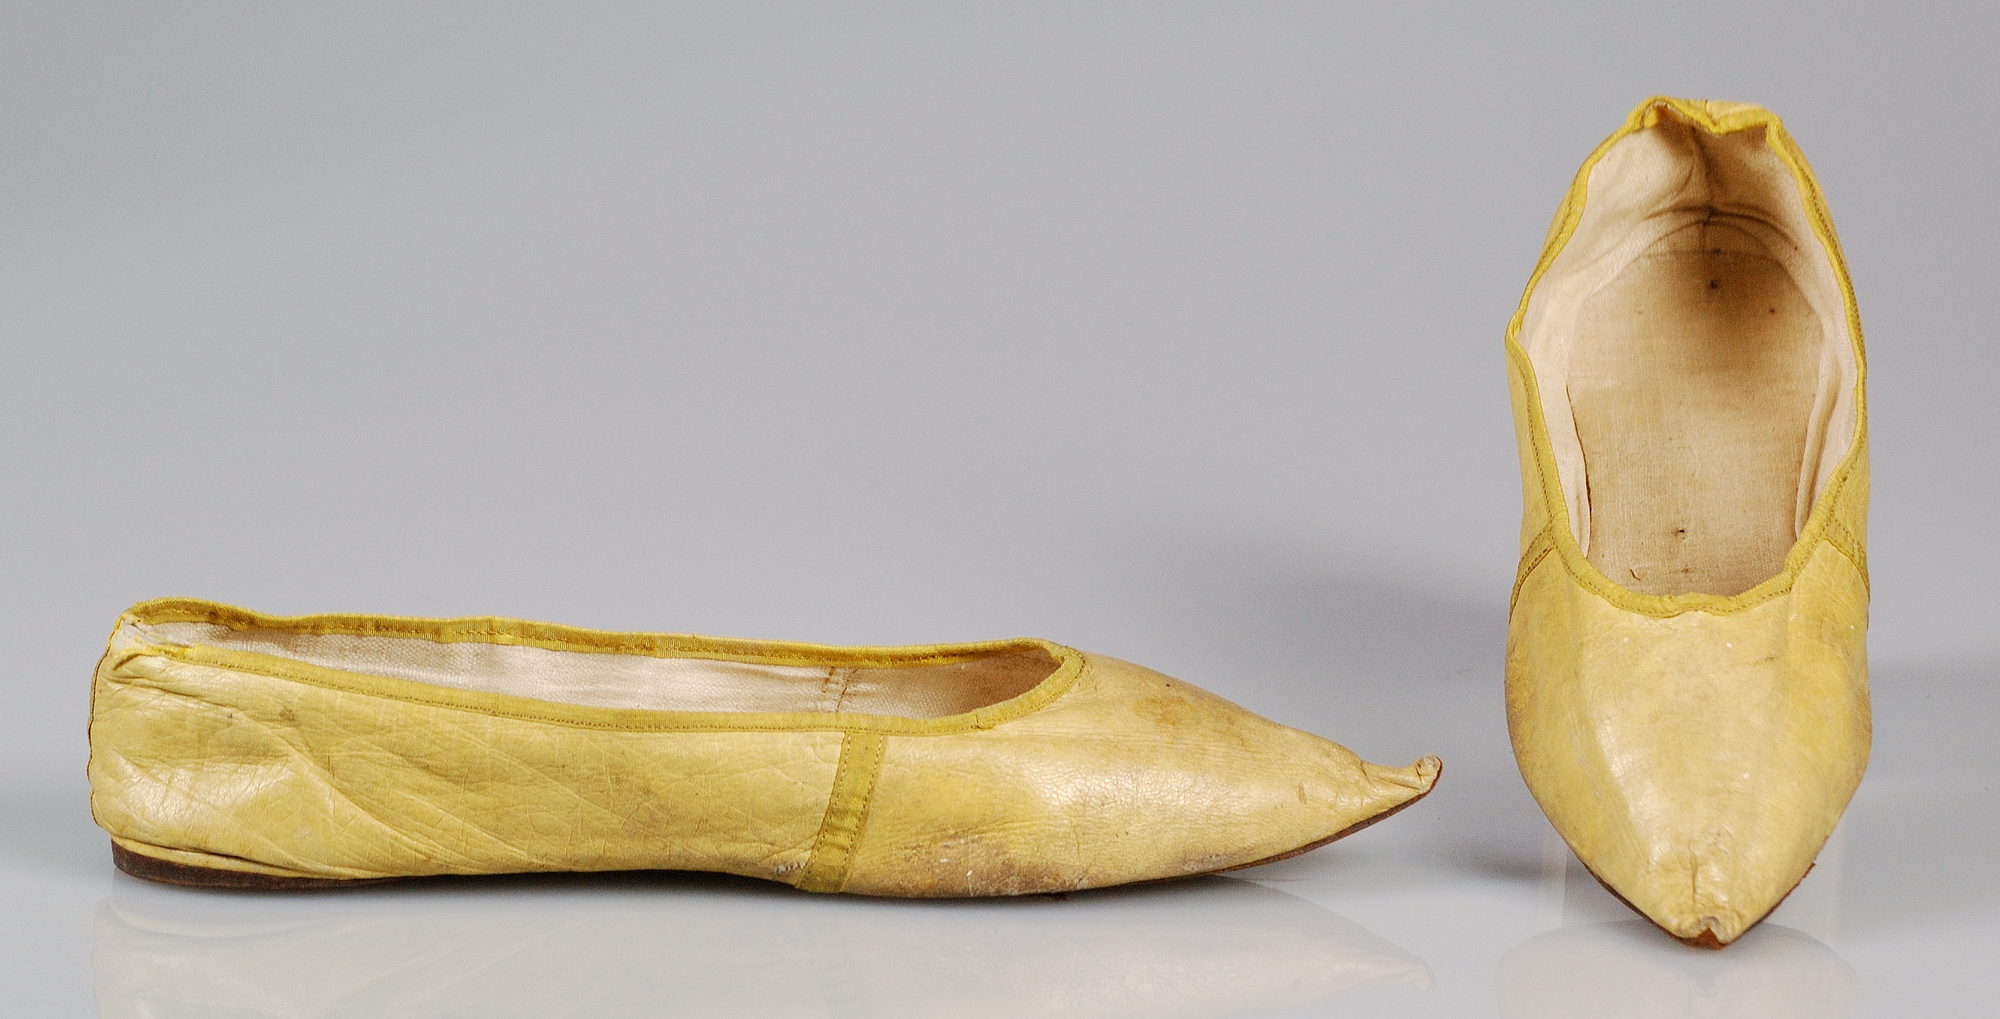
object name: slipper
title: Slippers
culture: british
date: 1795-1805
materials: leather